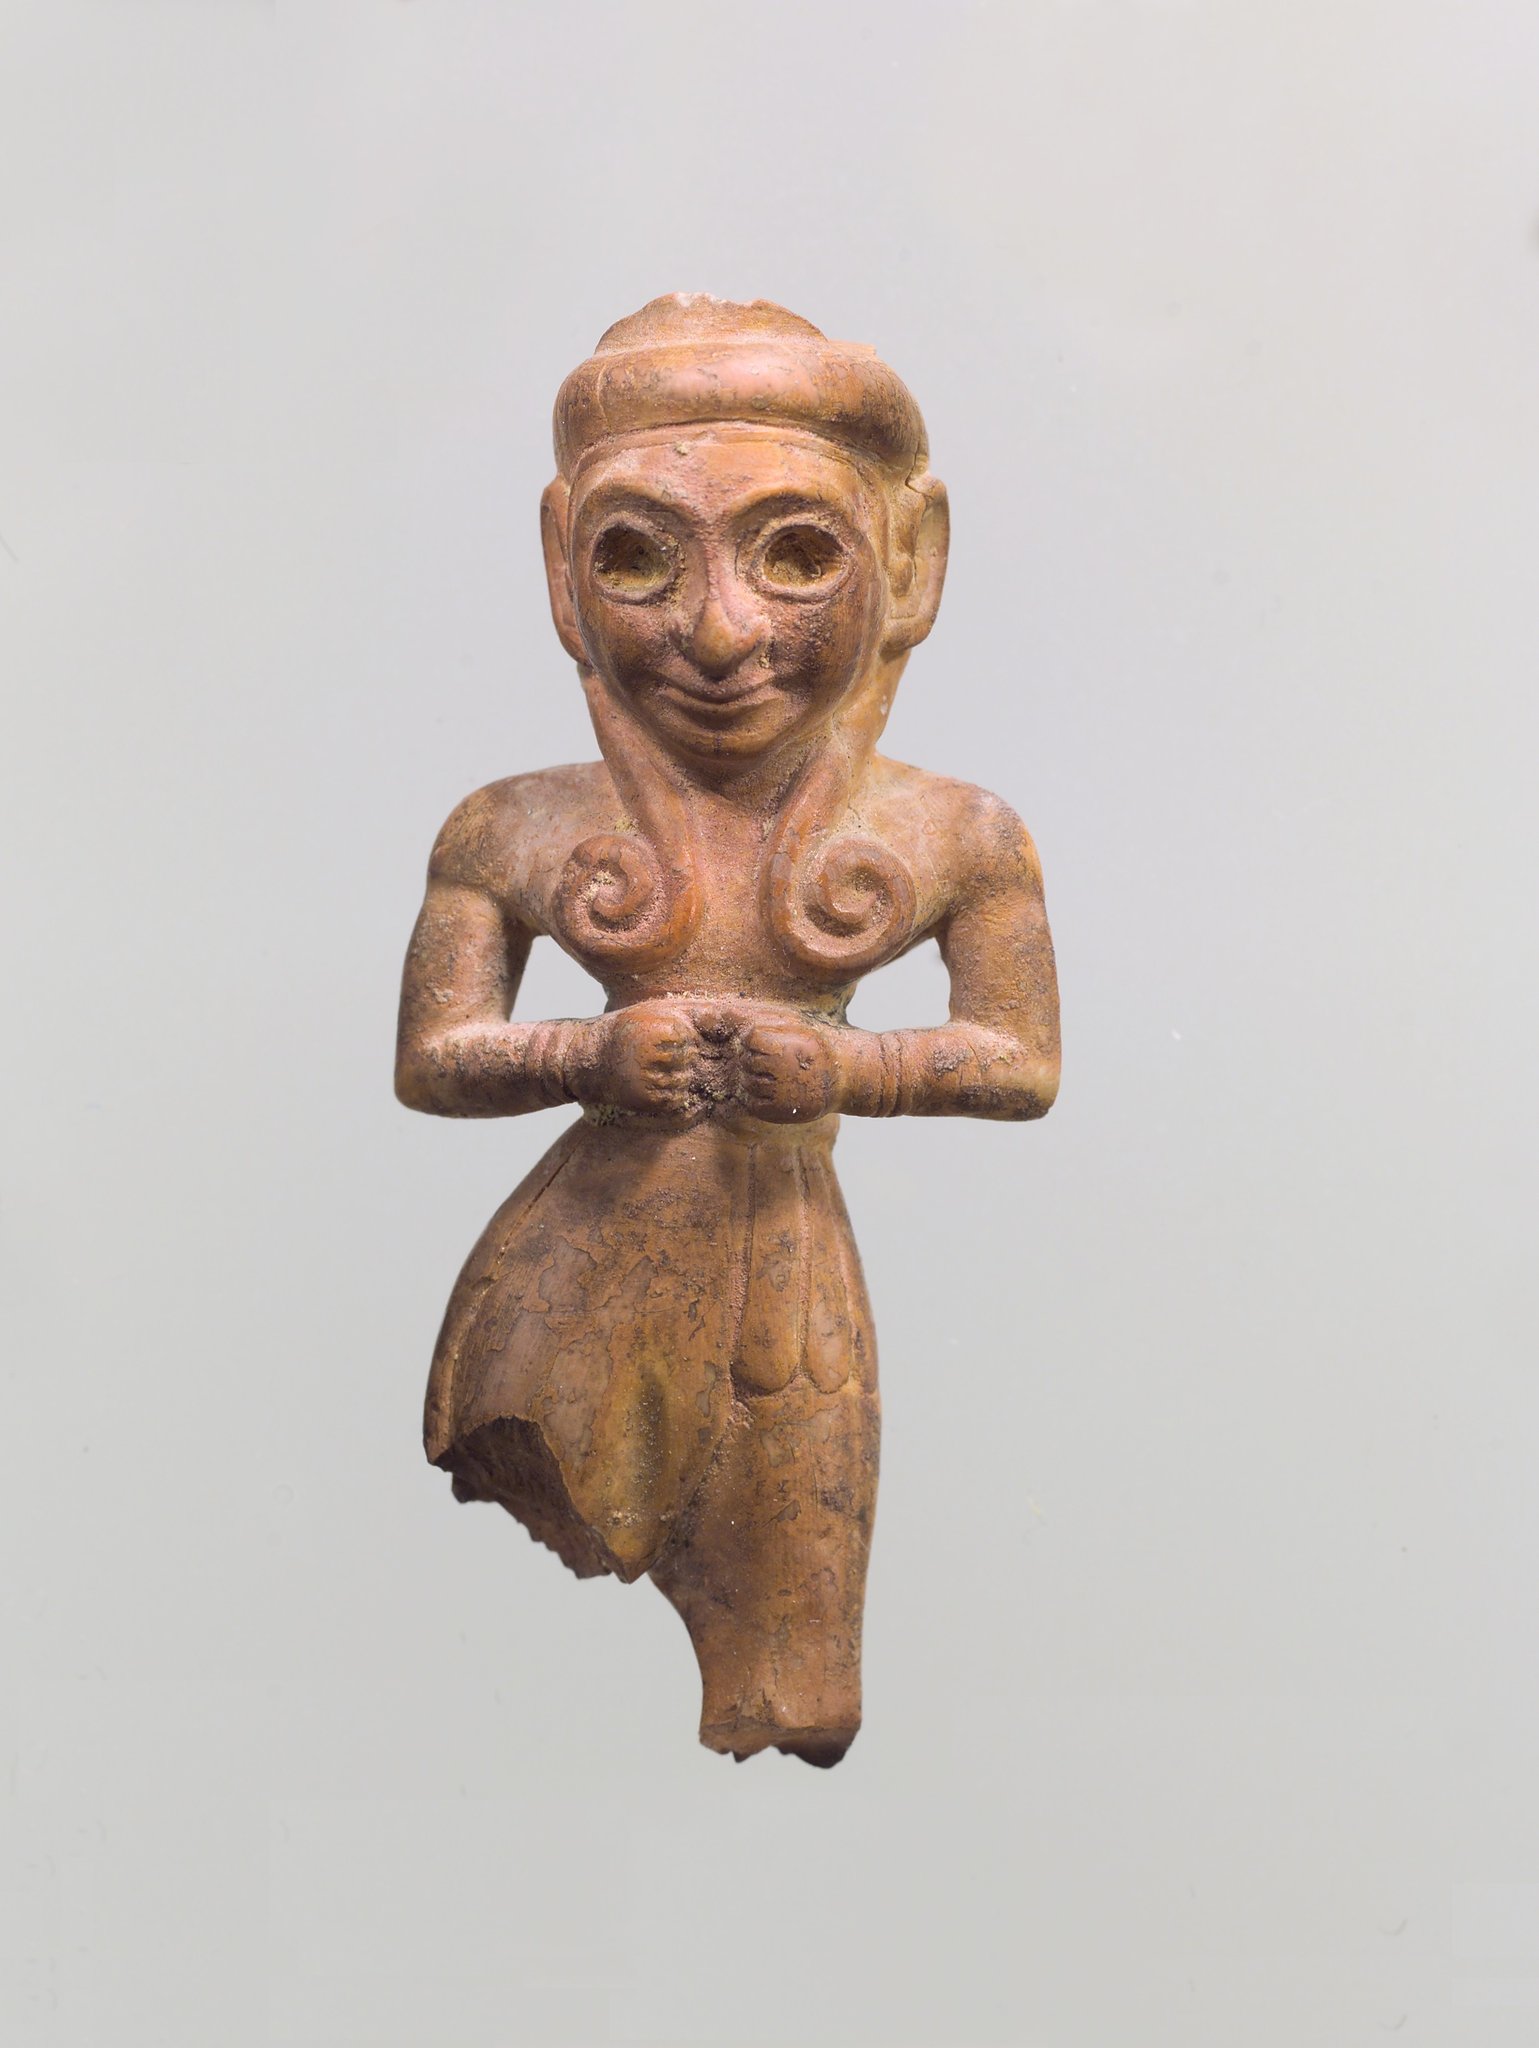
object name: furniture element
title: Furniture element: bull-man with Hathor-style curls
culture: assyrian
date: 1800-1701 BCE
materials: ivory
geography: anatolia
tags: men